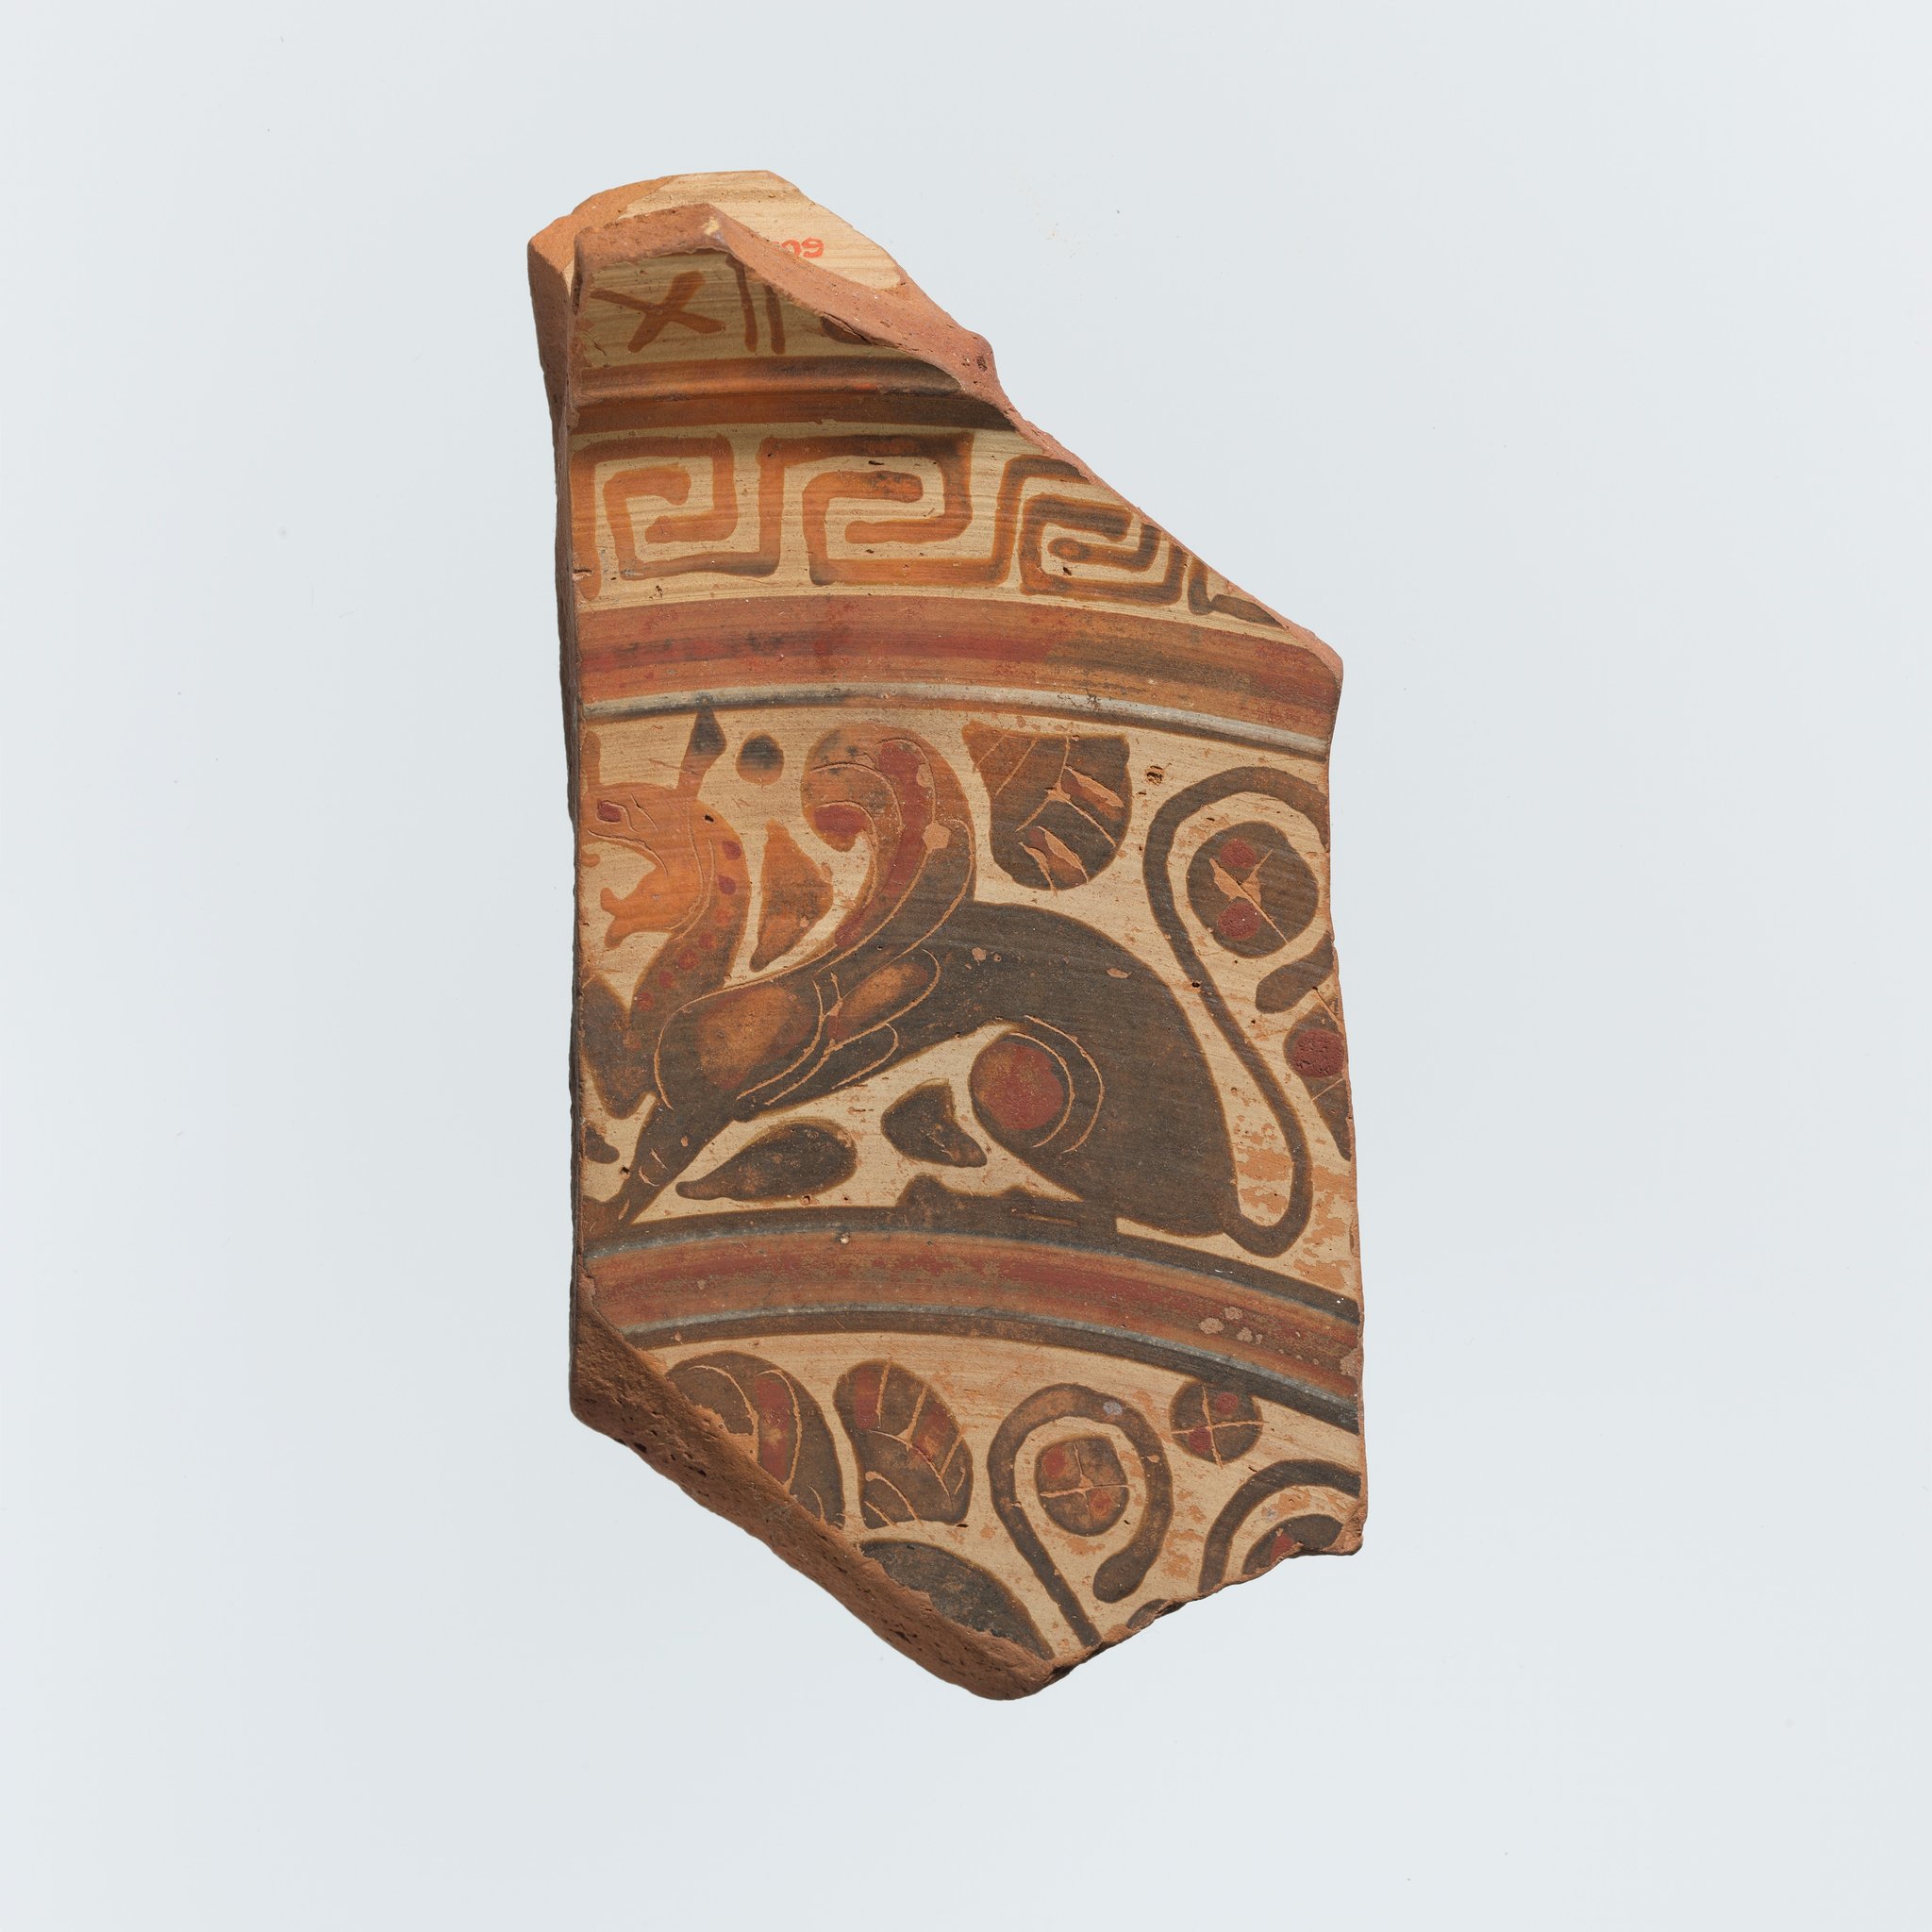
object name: plate fragment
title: Fragment of a terracotta plate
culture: greek, east, wild goat style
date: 700-601 BCE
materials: terracotta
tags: griffins